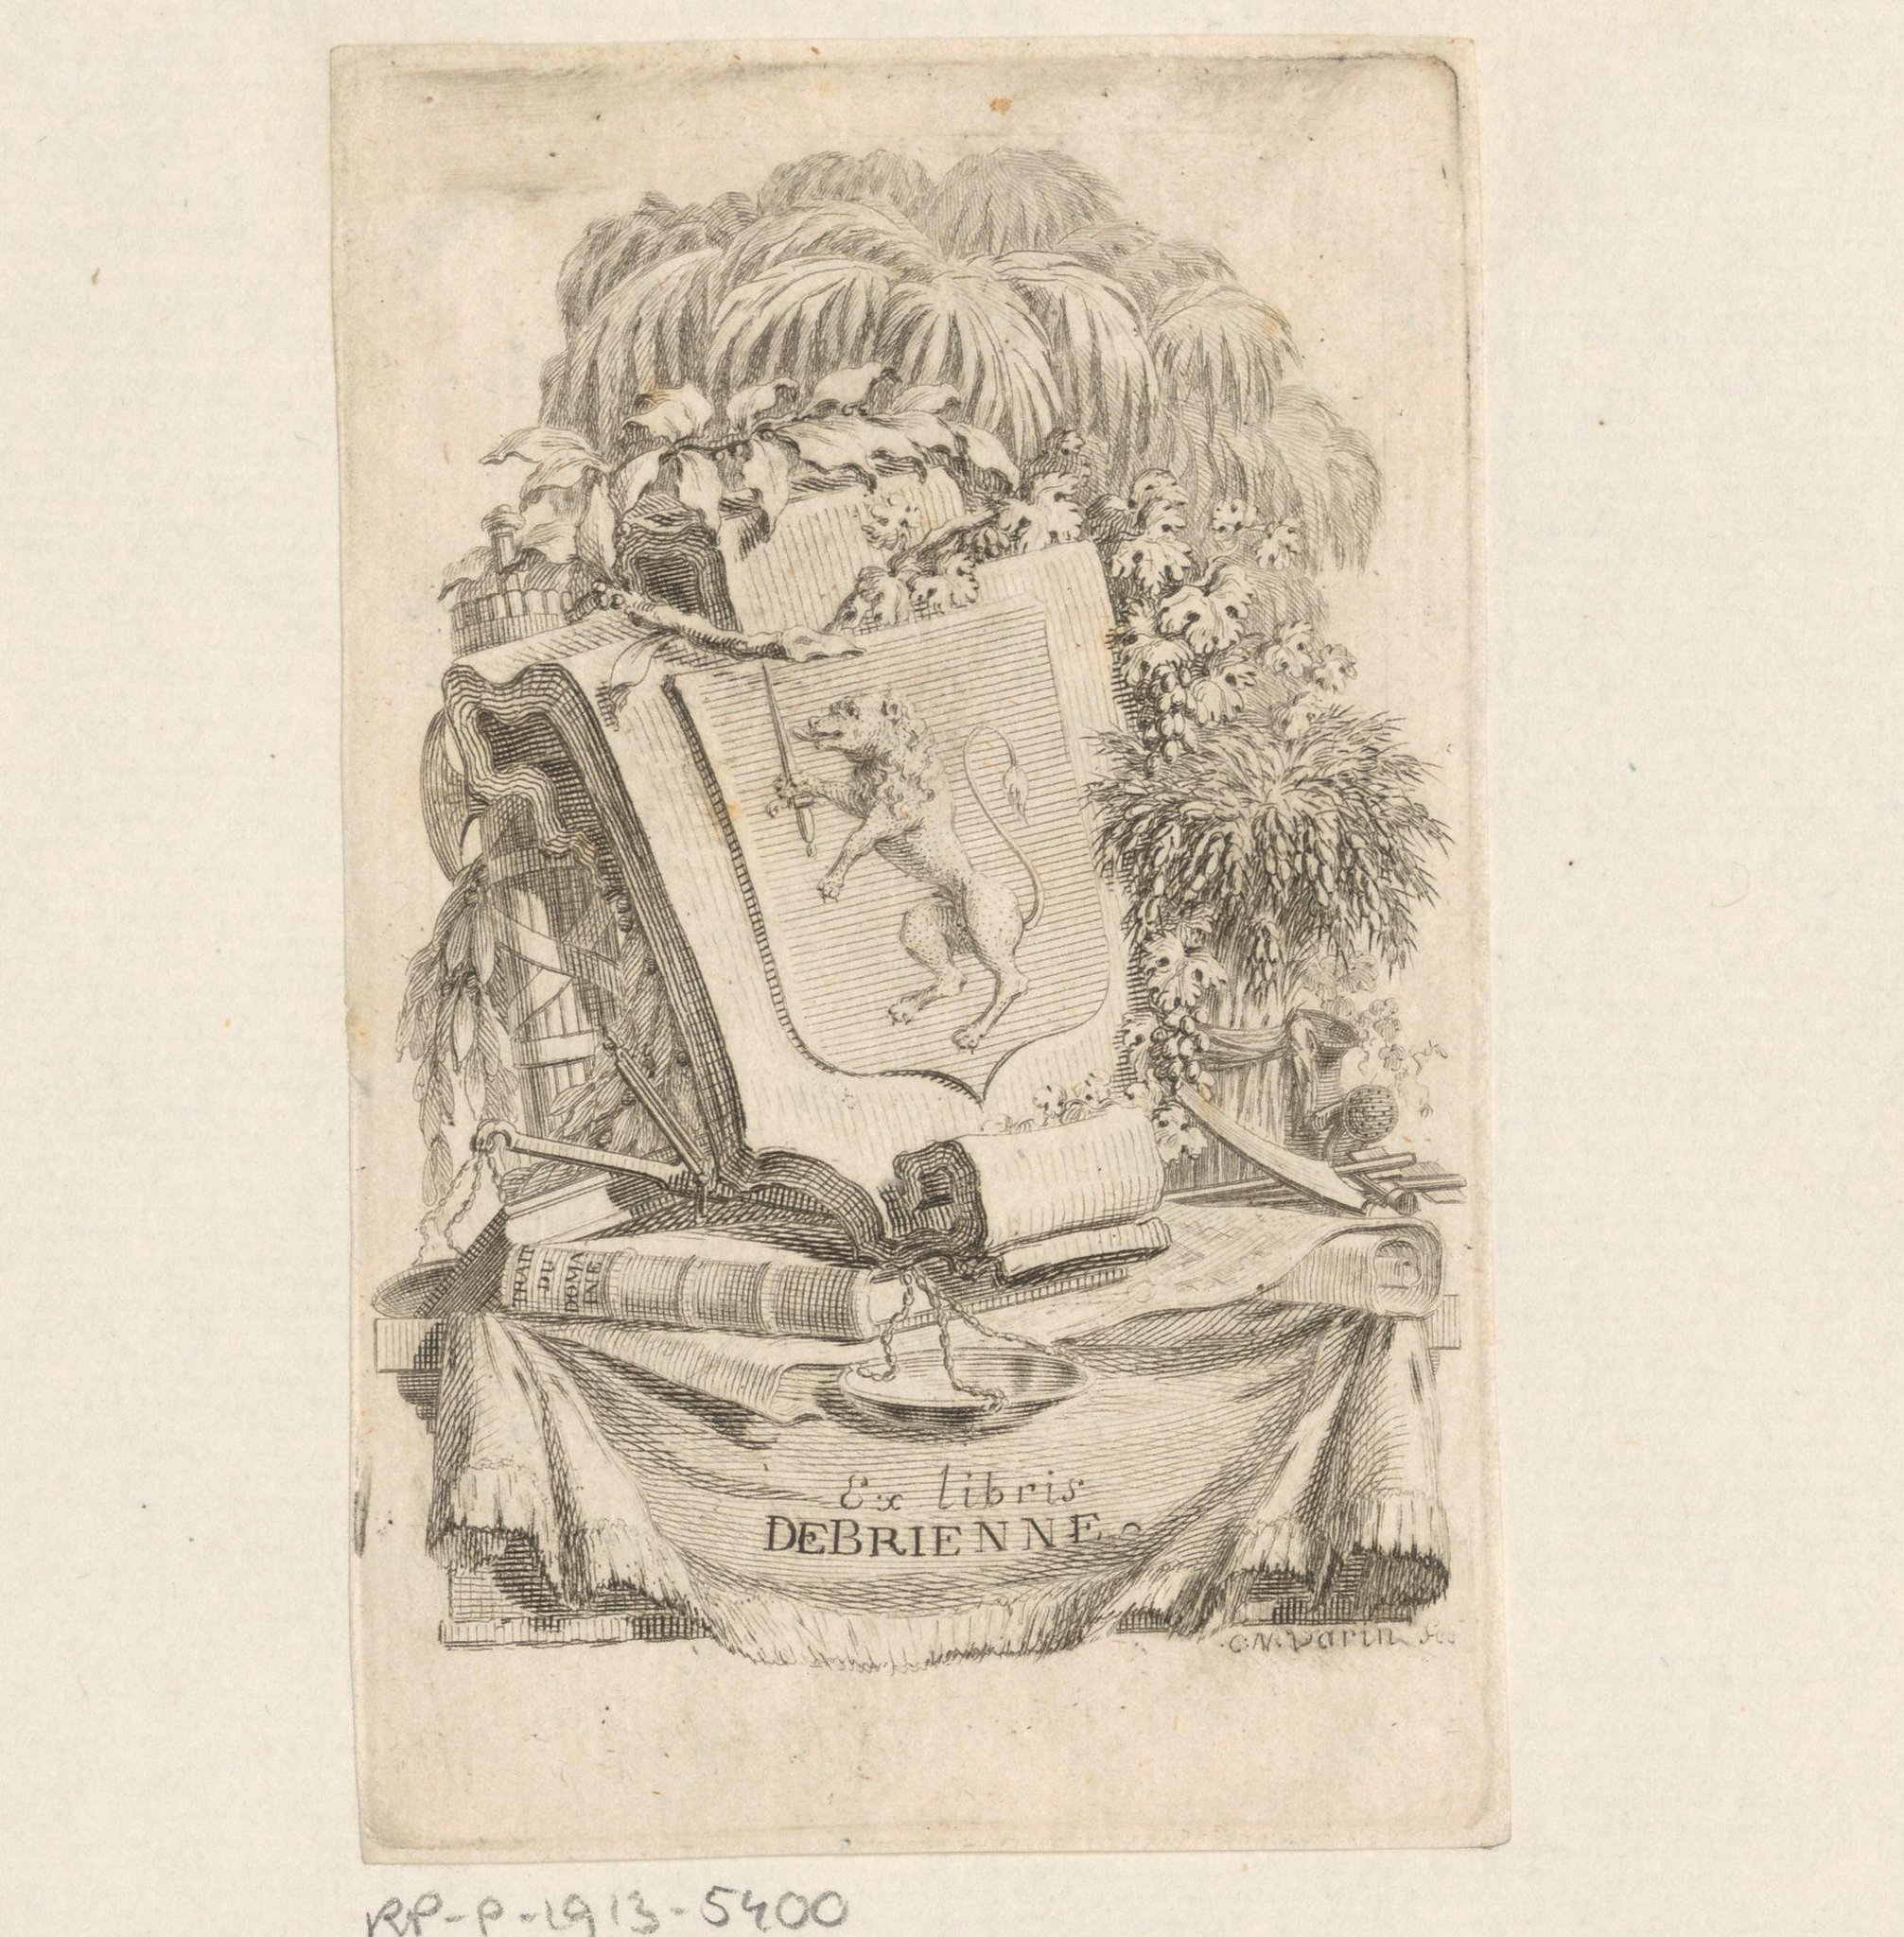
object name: bookplate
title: Ex libris van Debrienne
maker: charles nicolas varin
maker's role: print maker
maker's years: 1741-1812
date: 1751-1812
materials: paper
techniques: engraving, etching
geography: france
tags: book, law and jurisprudence, plants and herbs, beasts of prey, predatory animals: lion, armorial bearing, heraldry, weighing-instruments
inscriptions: collector's mark: Lugt 2233, collector's mark: Lugt 2760